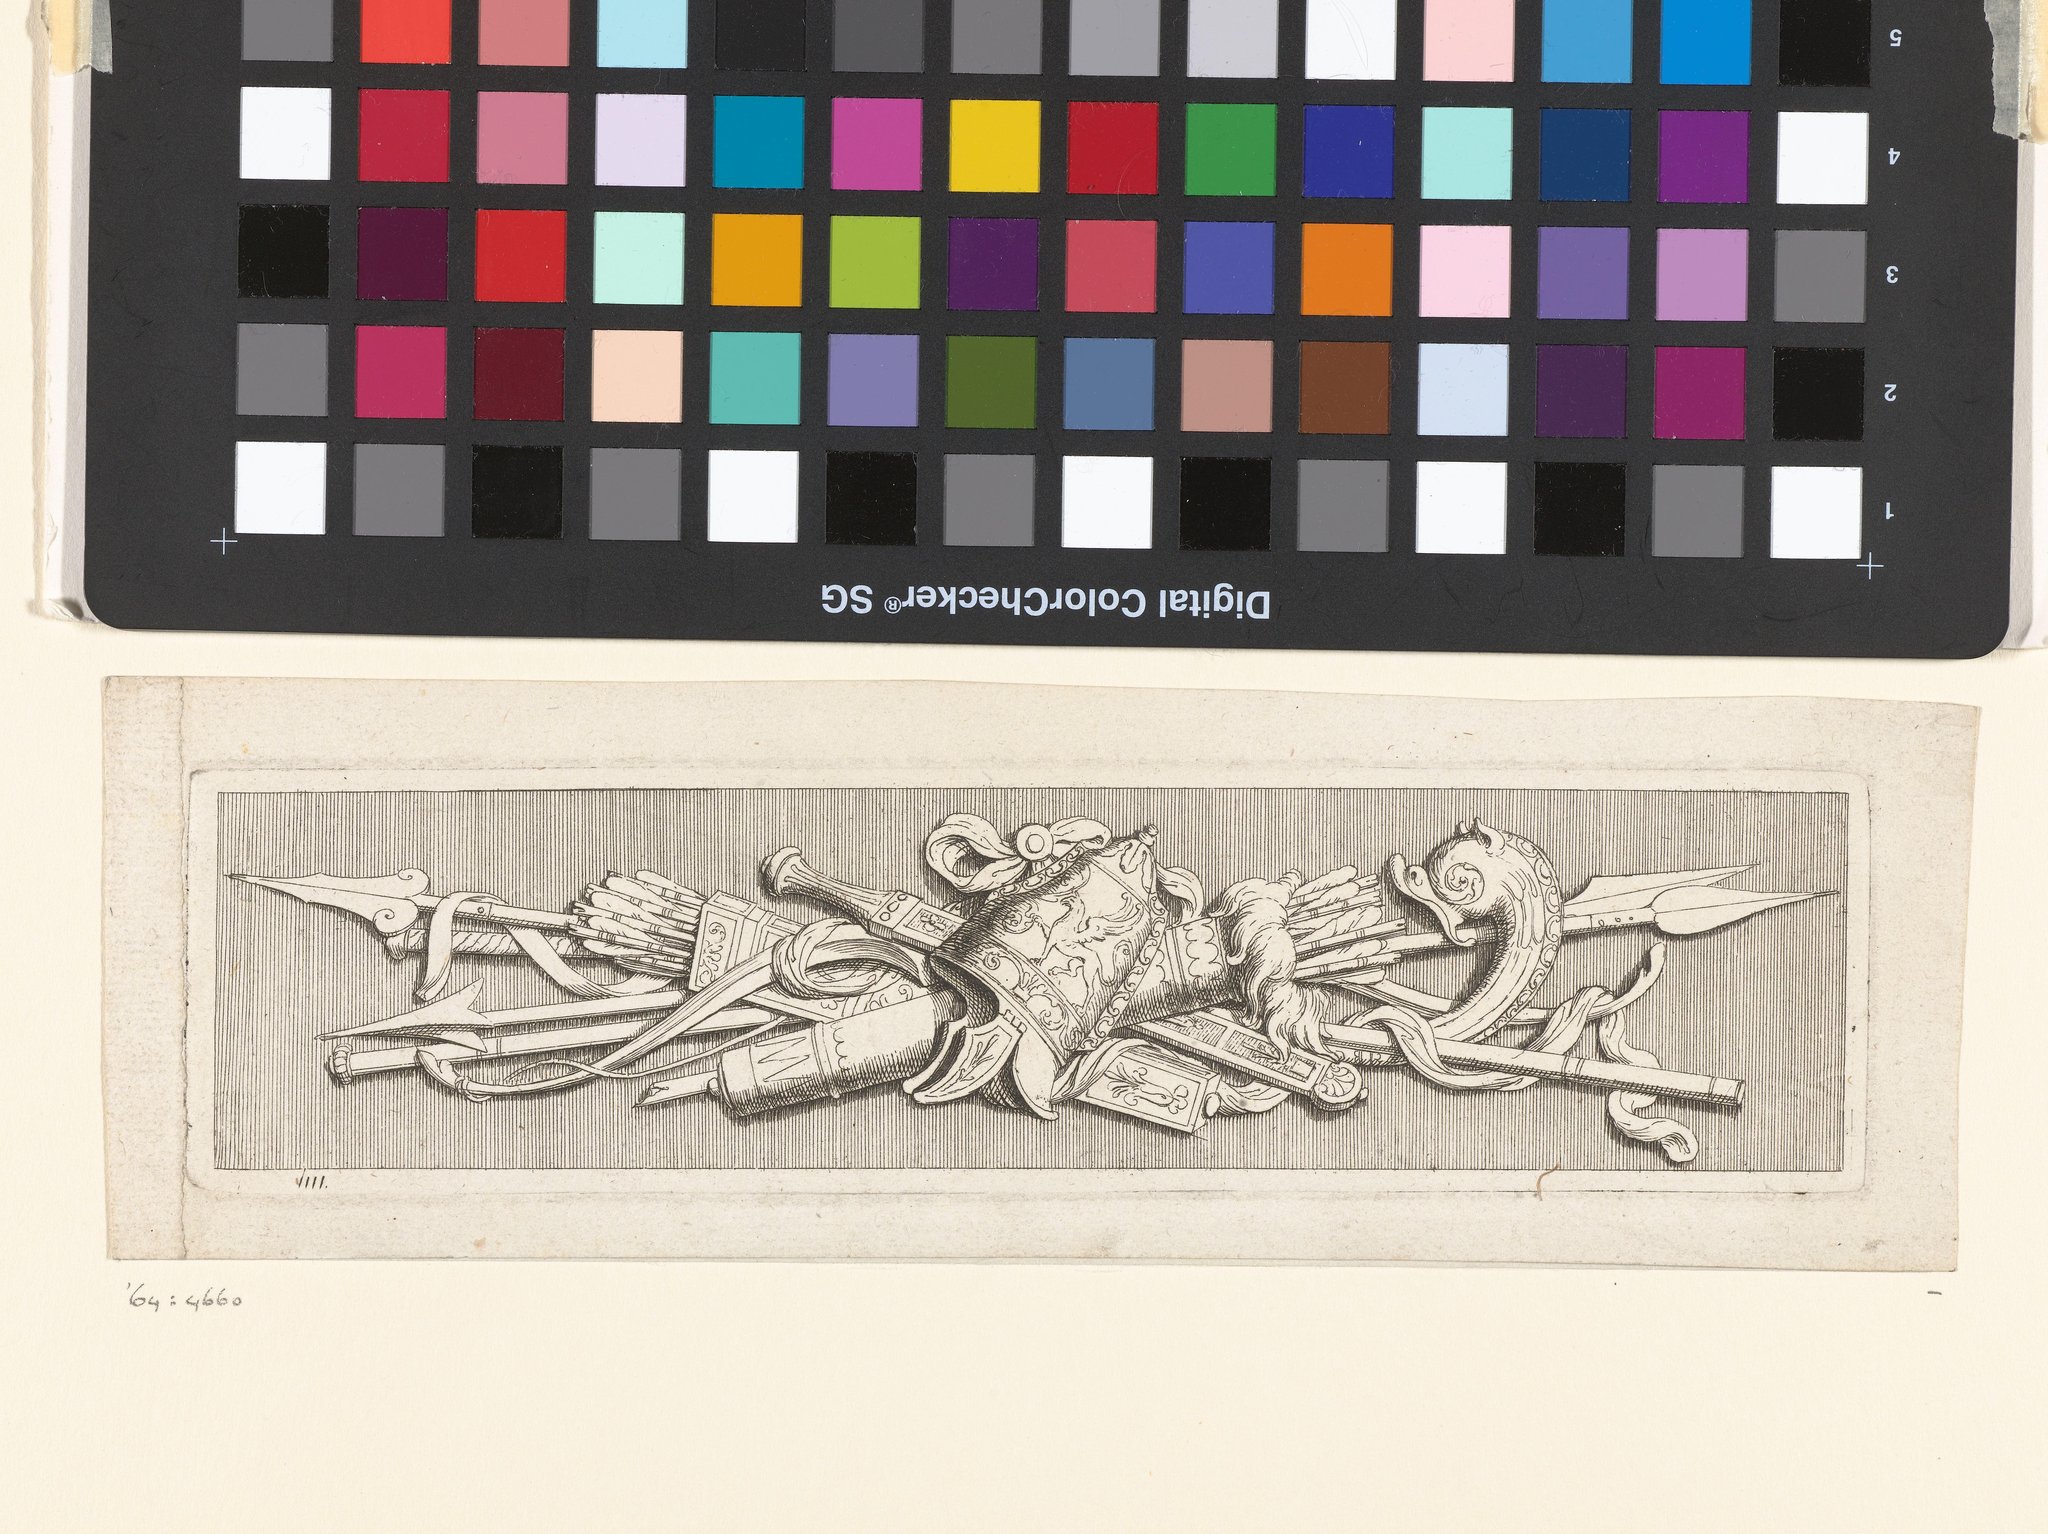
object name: print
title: Wapentrofeeën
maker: Anonymous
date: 1600-1699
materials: paper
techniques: etching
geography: france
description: De trofee bestaat uit speren, pijlen en een helm gedecoreerd met een griffioen. De achtergrond is gearceerd. Linksonder: IIII.